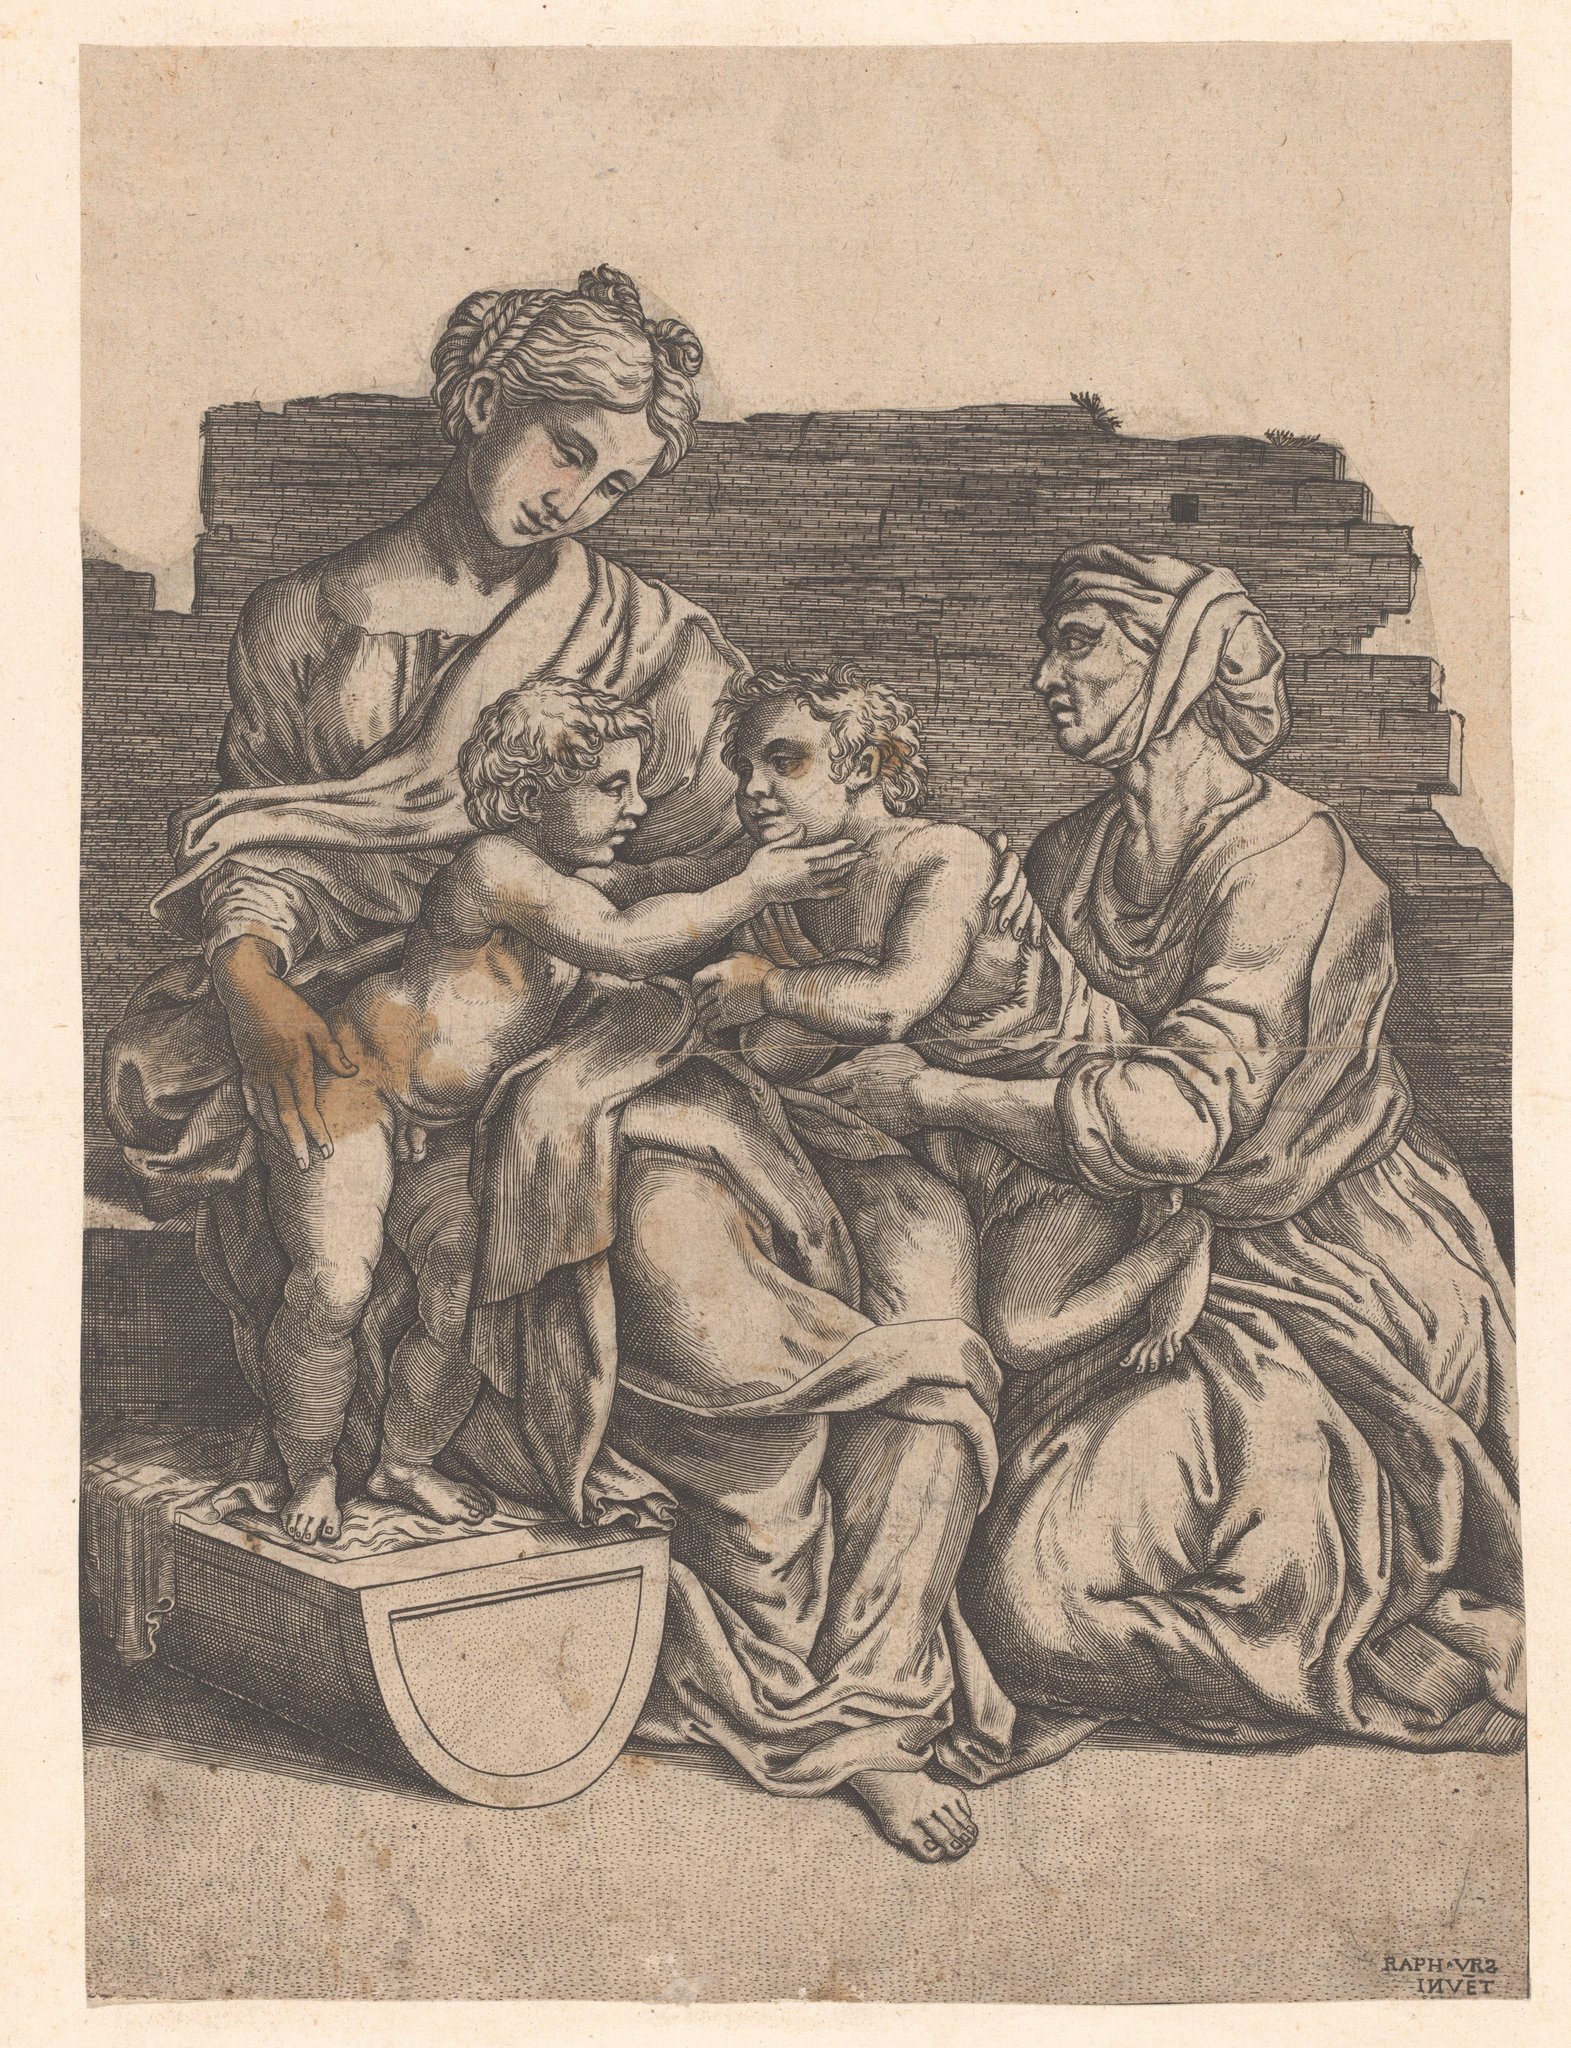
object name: print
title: Maria en Elisabet met Christuskind en Johannes de Doper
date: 1560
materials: paper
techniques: etching, snipping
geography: italy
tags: mary, the christ-child and john the baptist, elisabeth present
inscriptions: collector's mark: Lugt 2228, collector's mark: Lugt 567, collector's mark: Lugt 2760